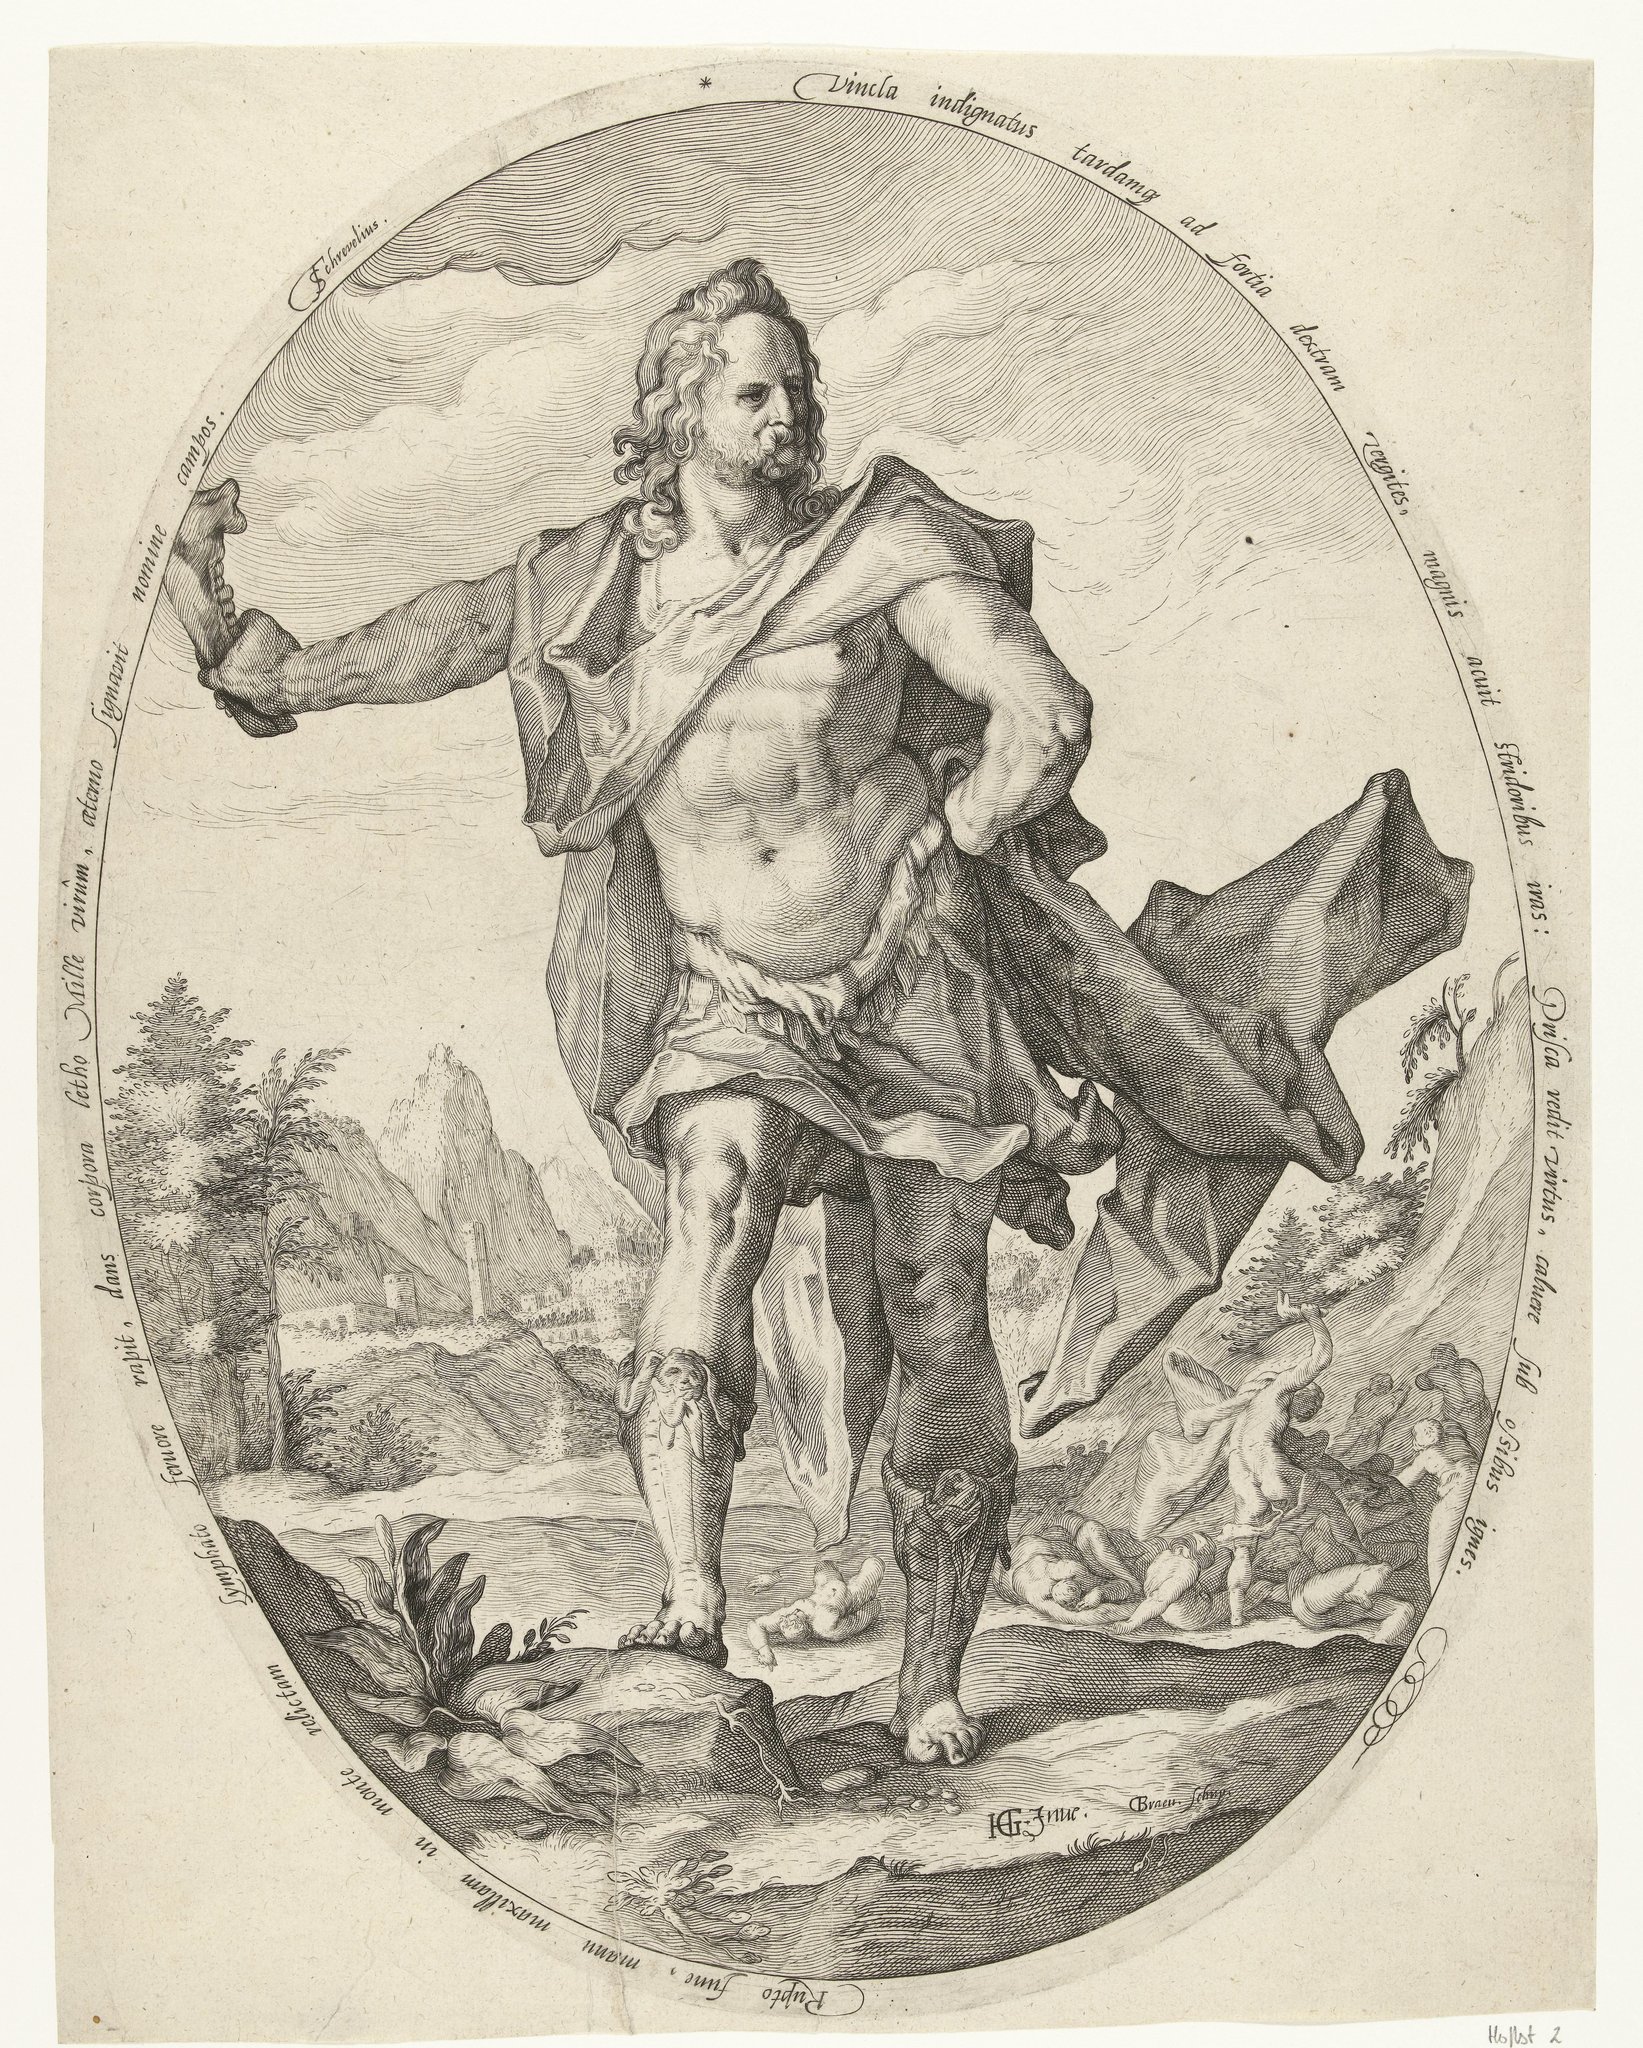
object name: print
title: Helden en heldinnen uit het Oude Testament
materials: paper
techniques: engraving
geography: haarlem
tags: with an ass's jaw-bone samson slays a thousand philistines, samson (not in biblical context); possible attributes: broken pillar, club, jawbone, lion's head, lion's pelt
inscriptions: collector's mark: Lugt 240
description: Simson met het kaakbeen van een ezel in zijn hand, de andere hand in zijn zij. Op de achtergrond is te zien hoe Simson met het kaakbeen de Filistijnen verslaat omdat ze hem bespot hebben. In ovaal met randschrift in het Latijn door Theodorus Schrevelius.